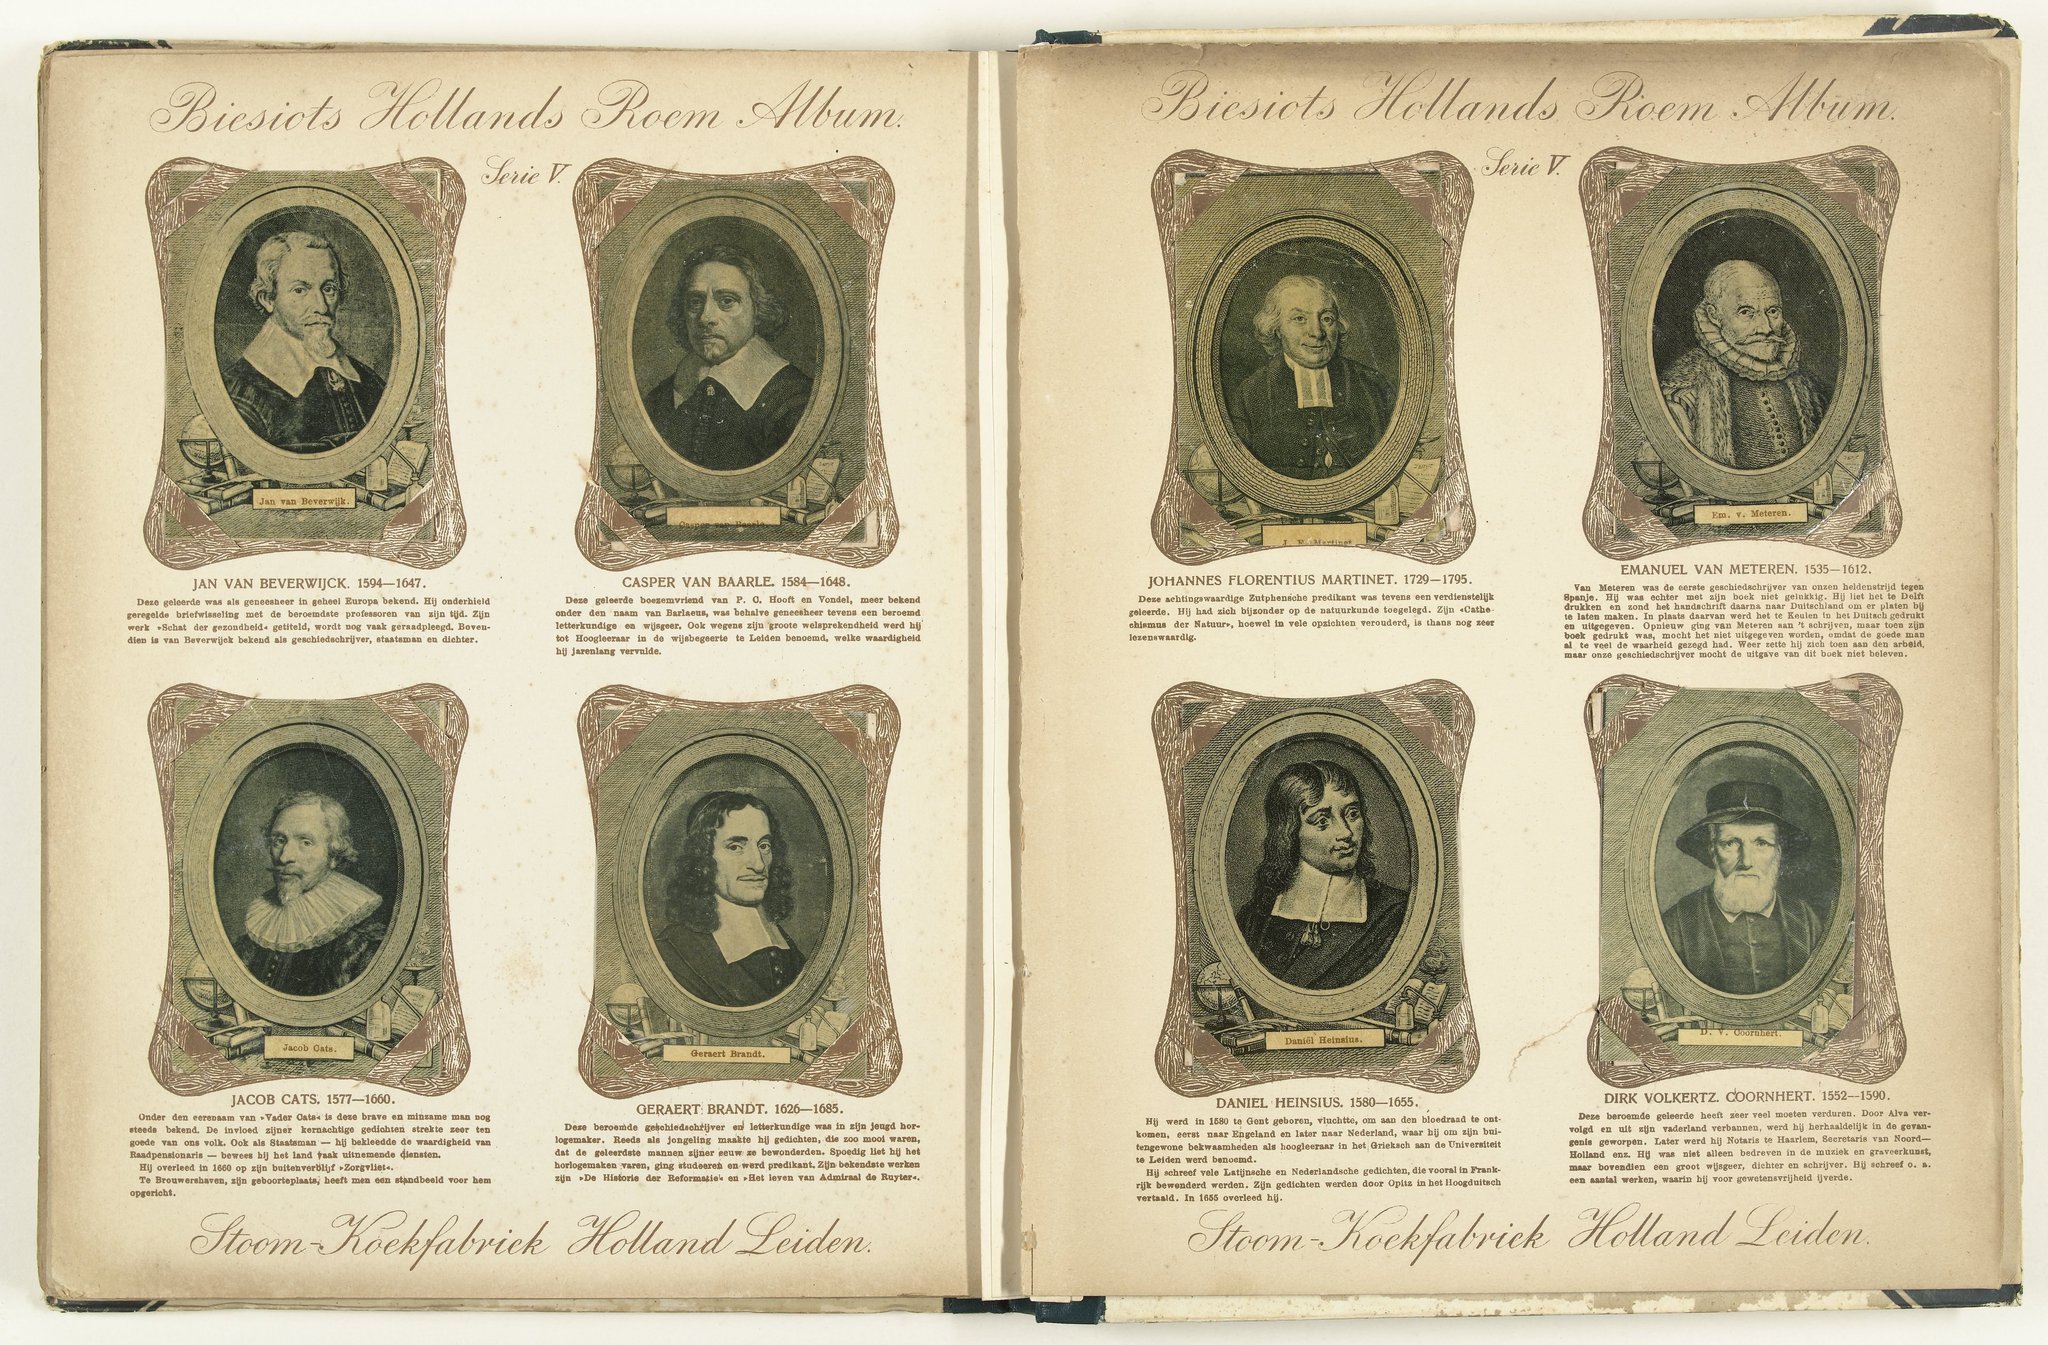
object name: album leaf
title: Portretten van geleerden en schrijvers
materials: cardboard, paper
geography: leiden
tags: historical persons, netherlands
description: Acht portretten van geleerden en schrijvers. Pag. 28: Van Beverwijck, Arts, Barleaus, geleerde, Cats, dichter en Brandt, geschiedschrijver. Pagina 29: Martinet, predikant en natuurkundige, Van Meteren, geschiedschrijver, Heinsius, Hoogleraar Grieks en Coornhert, wijsgeer, dichter en schrijver. Pagina uit Biesiots Holland's Roem Album.